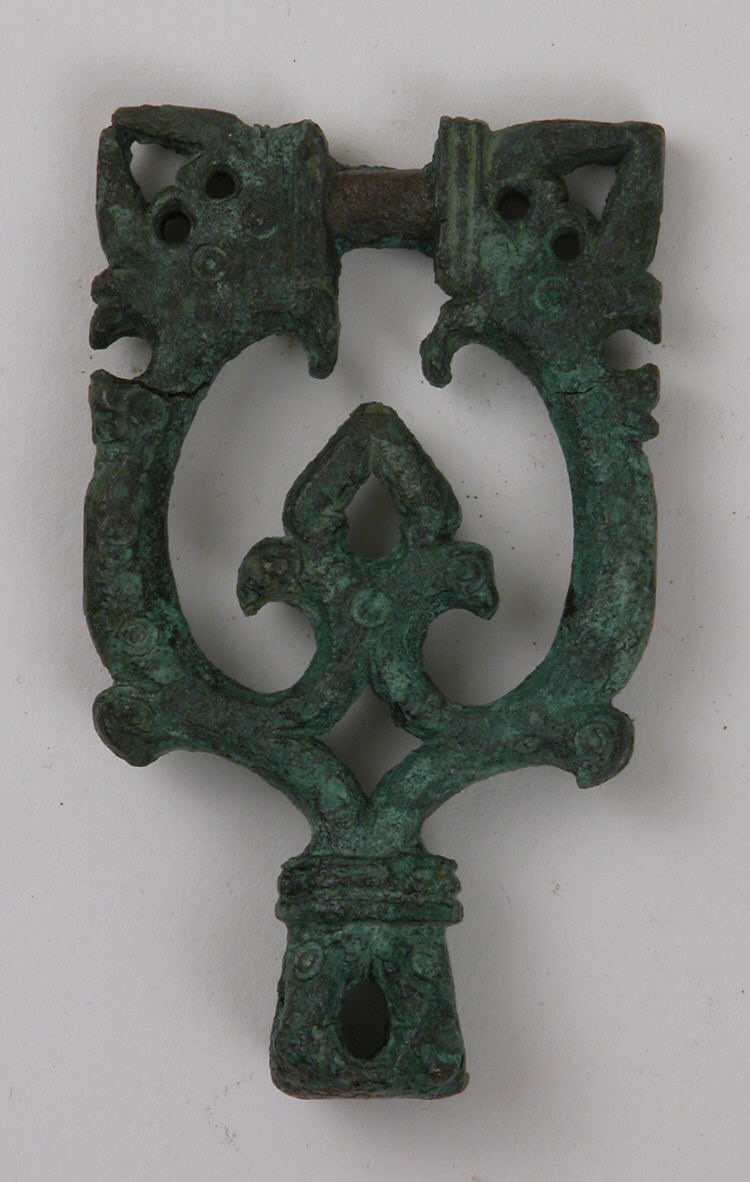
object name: finial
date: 901-1200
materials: bronze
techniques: casting, chasing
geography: egypt